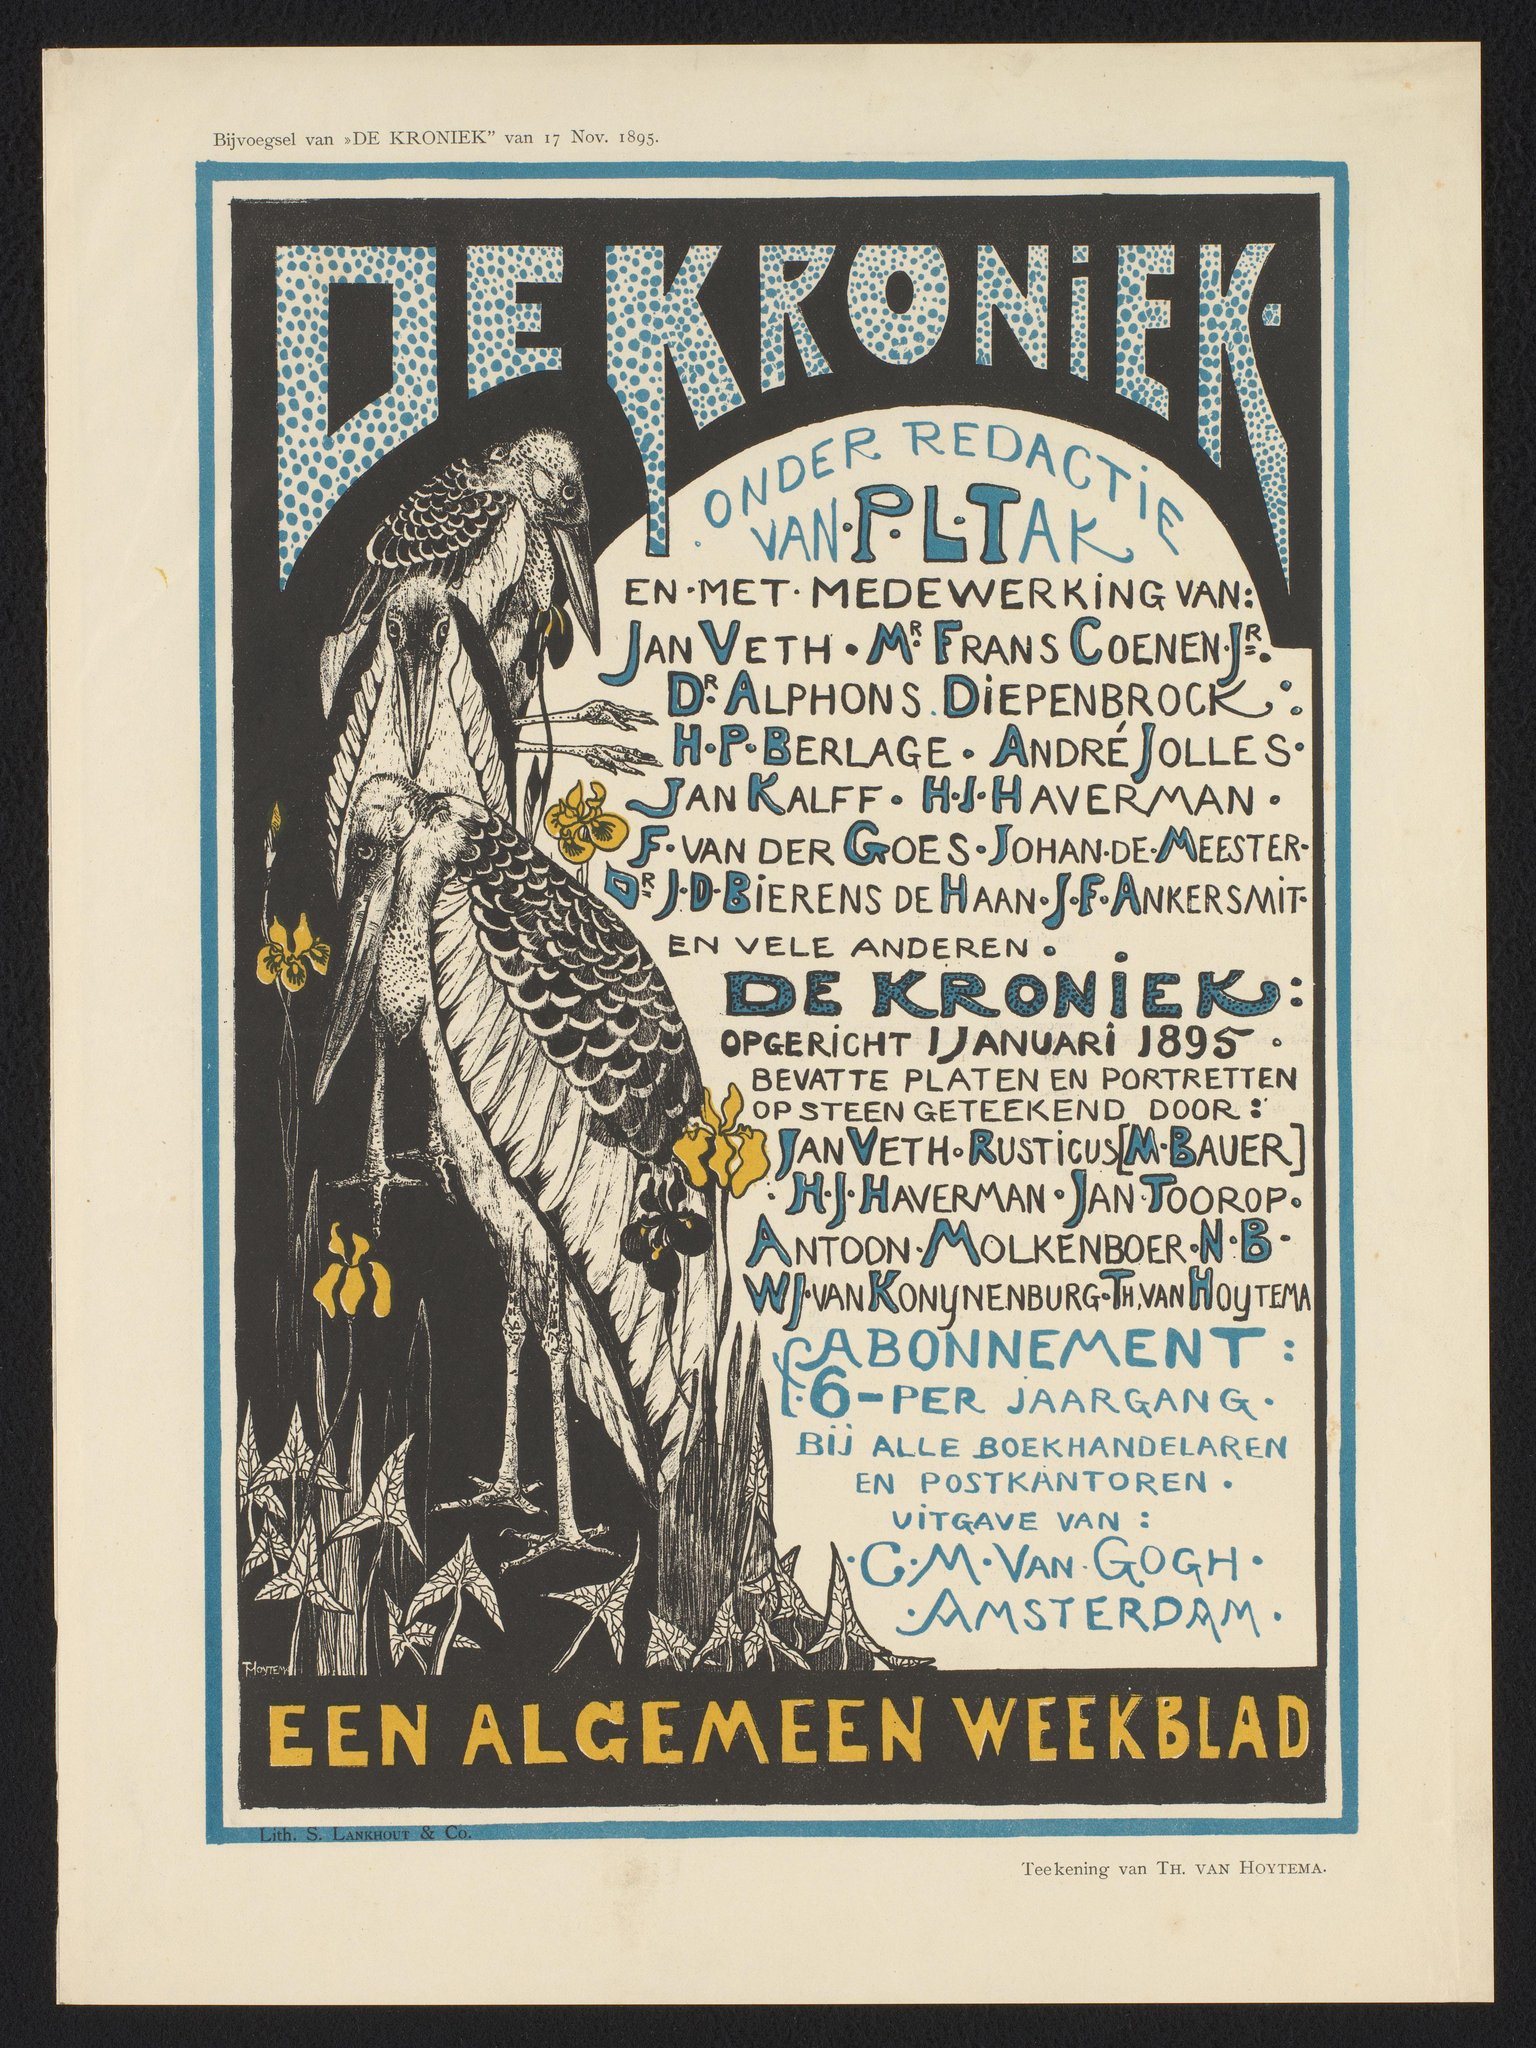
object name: poster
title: Affiche ter aankondiging van het tijdschrift 'De kroniek'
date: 1895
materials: paper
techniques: lithograph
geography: amsterdam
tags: birds, flowers: lily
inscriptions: collector's mark: Lugt 2760, collector's mark: Lugt 2228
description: Deze prent was een bijlage van: De kroniek, een algemeen weekblad 1 (1895), 17 november 1895.